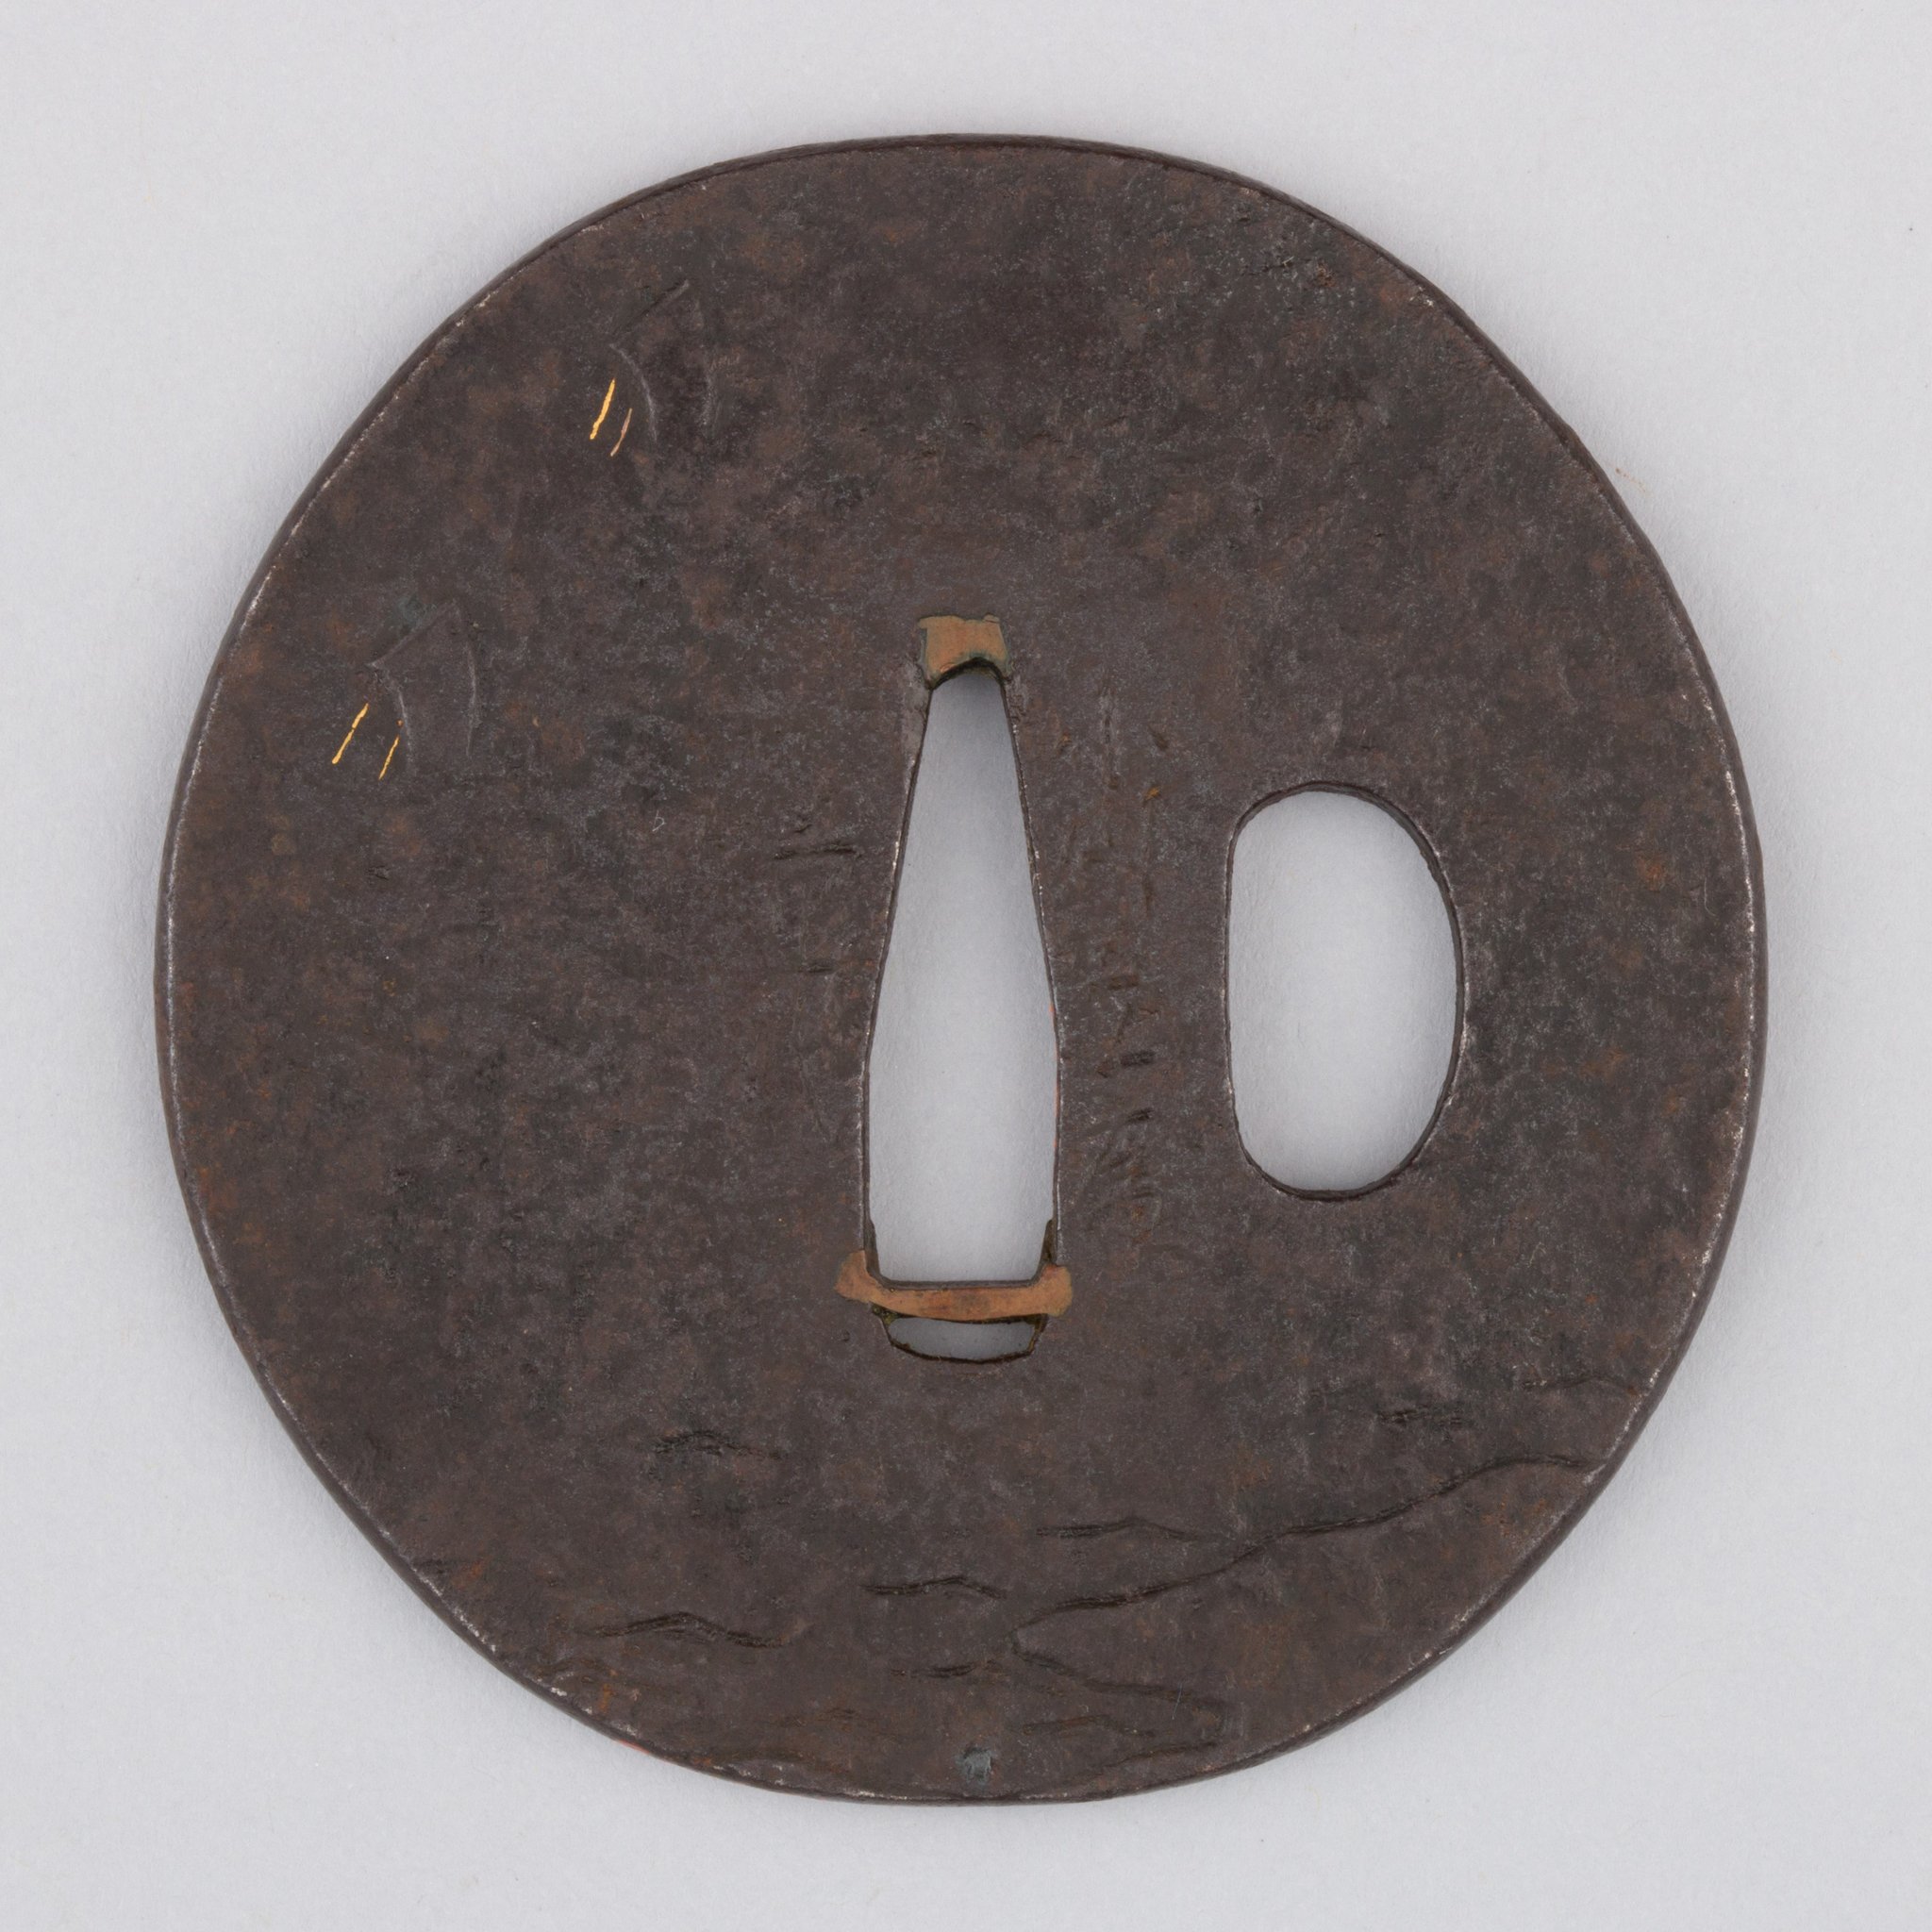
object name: sword guard tsuba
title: Sword Guard (Tsuba)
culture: japanese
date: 1615-1868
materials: copper, iron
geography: japan